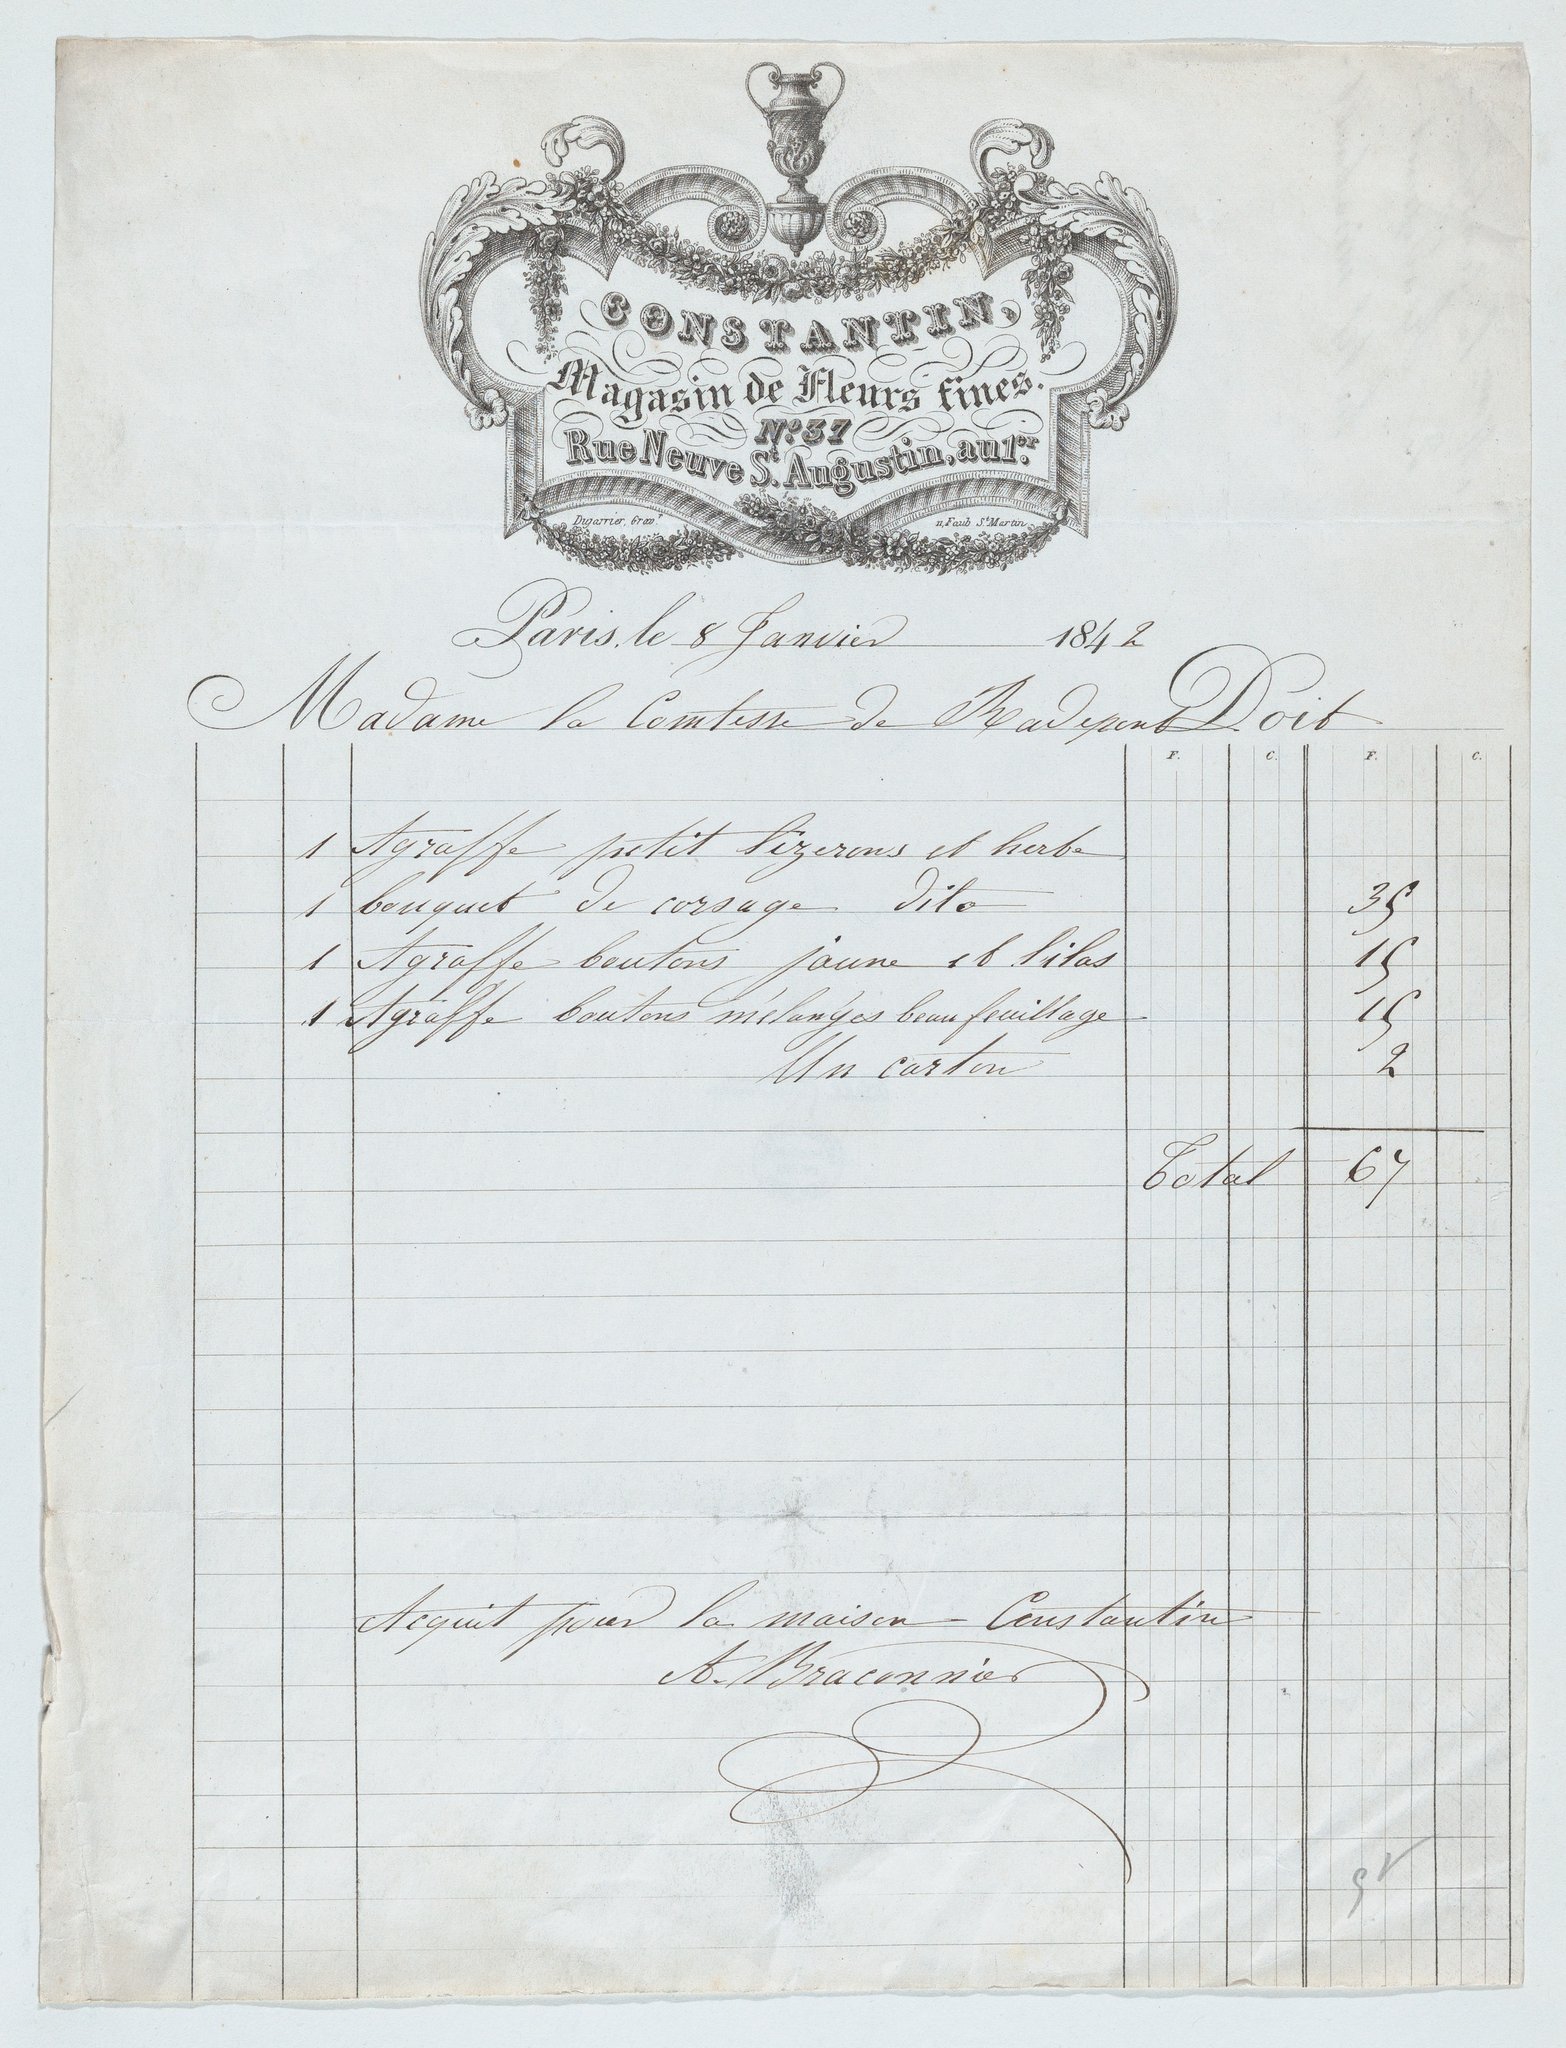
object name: print, ephemera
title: Invoice from Constantin Magasin de Fleurs fines, Paris, for plants and flowers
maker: constantin magasin des fleurs fines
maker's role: retailer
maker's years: 1800-1900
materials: ink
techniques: engraving, pen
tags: documents